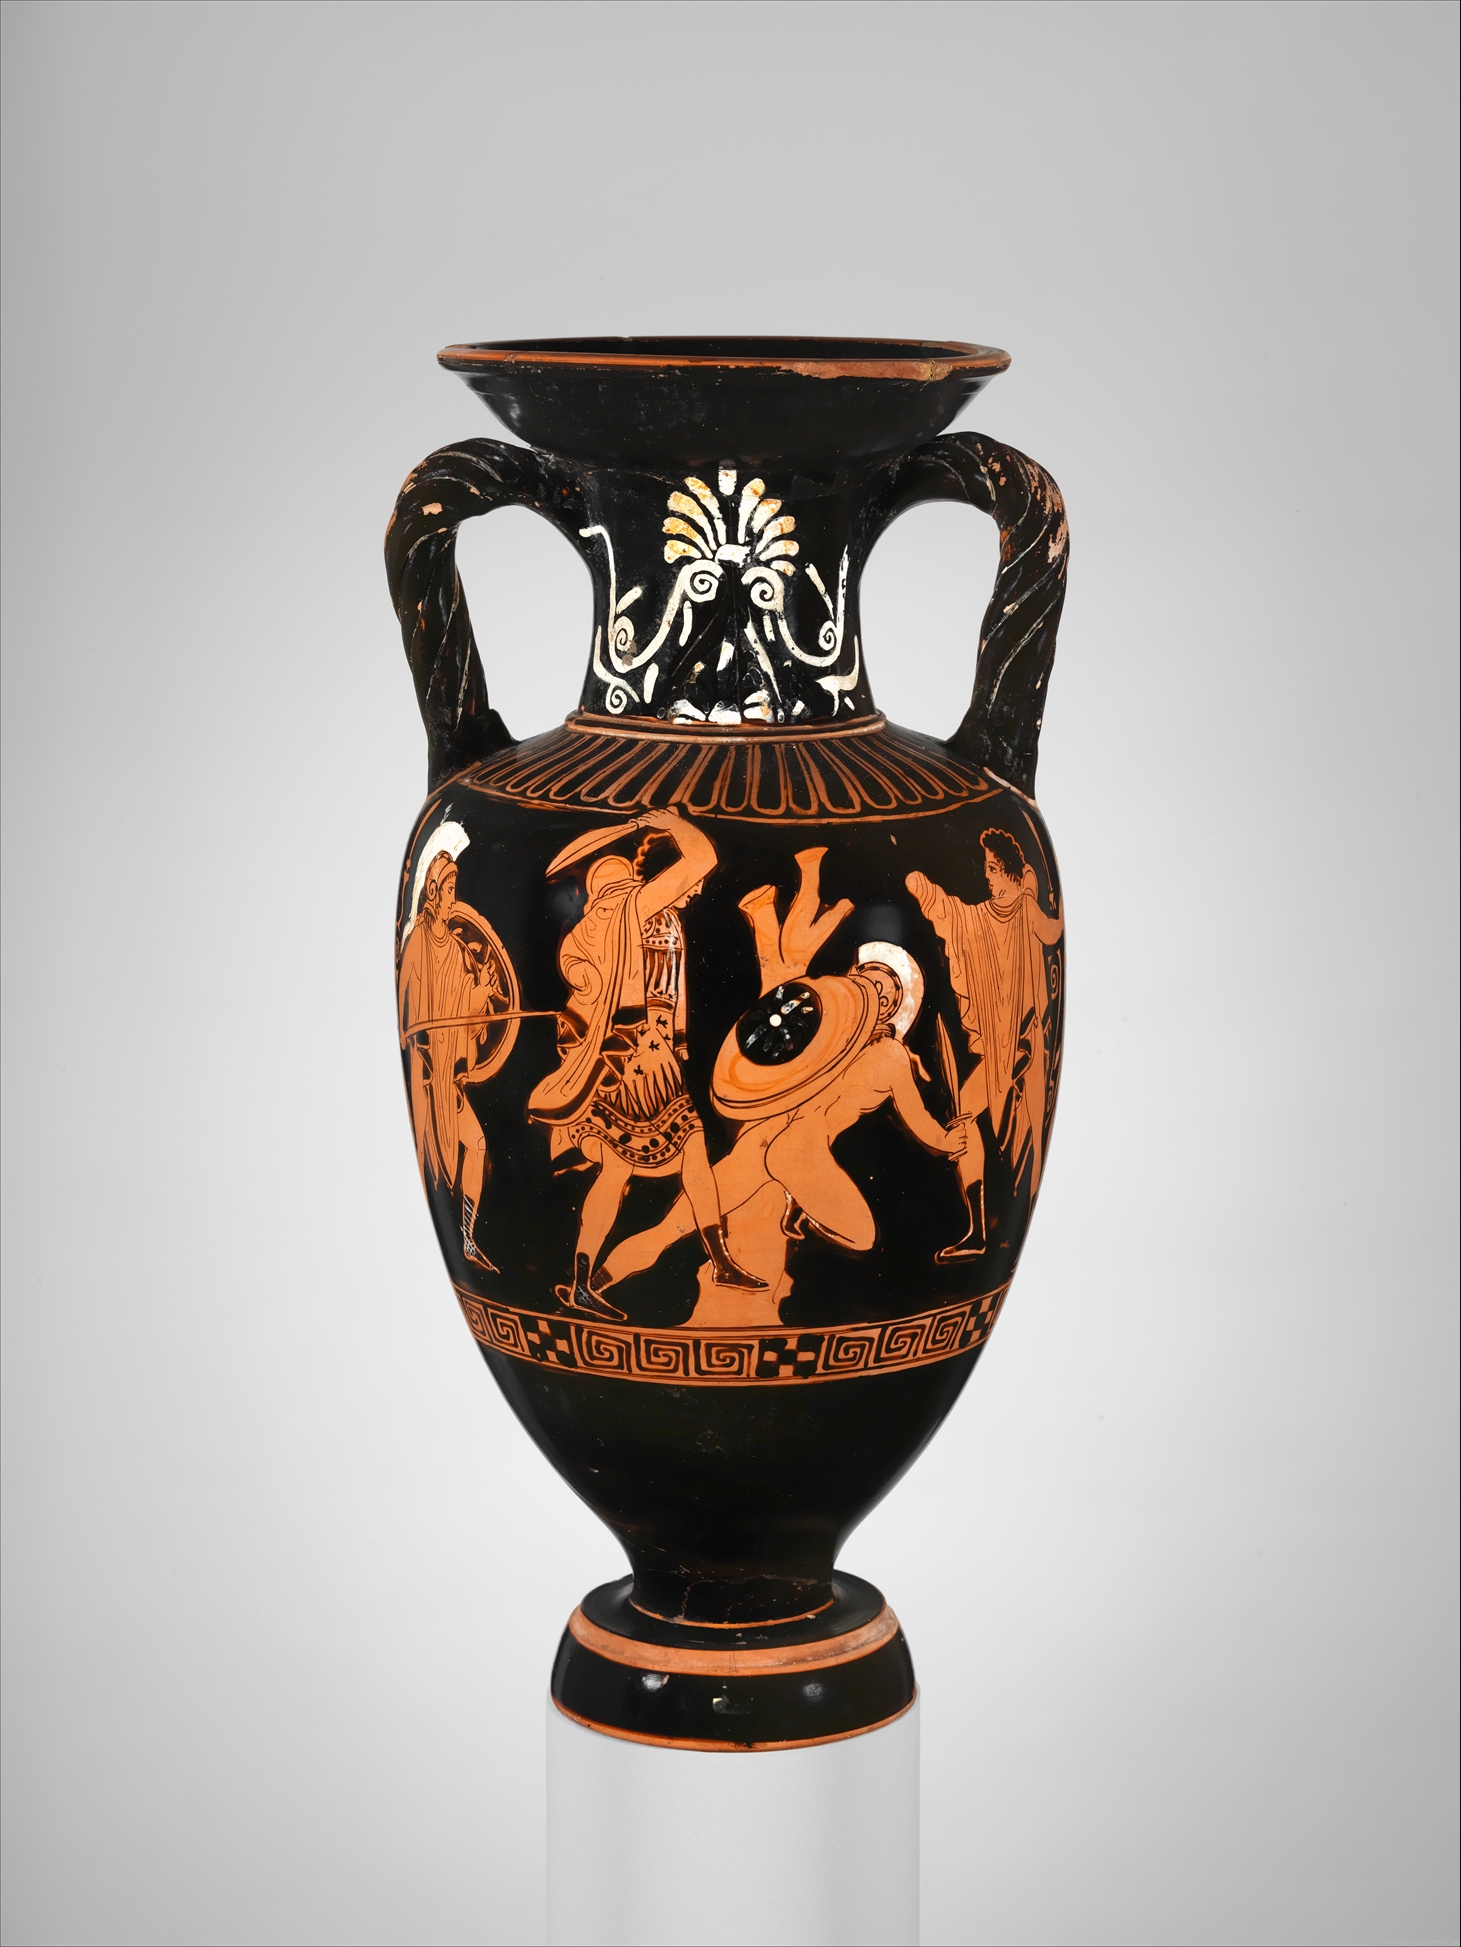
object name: neck amphora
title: Terracotta neck-amphora (jar) with twisted handles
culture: greek, attic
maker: suessula painter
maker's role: artist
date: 400 BCE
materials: terracotta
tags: amazons,maenads,satyrs